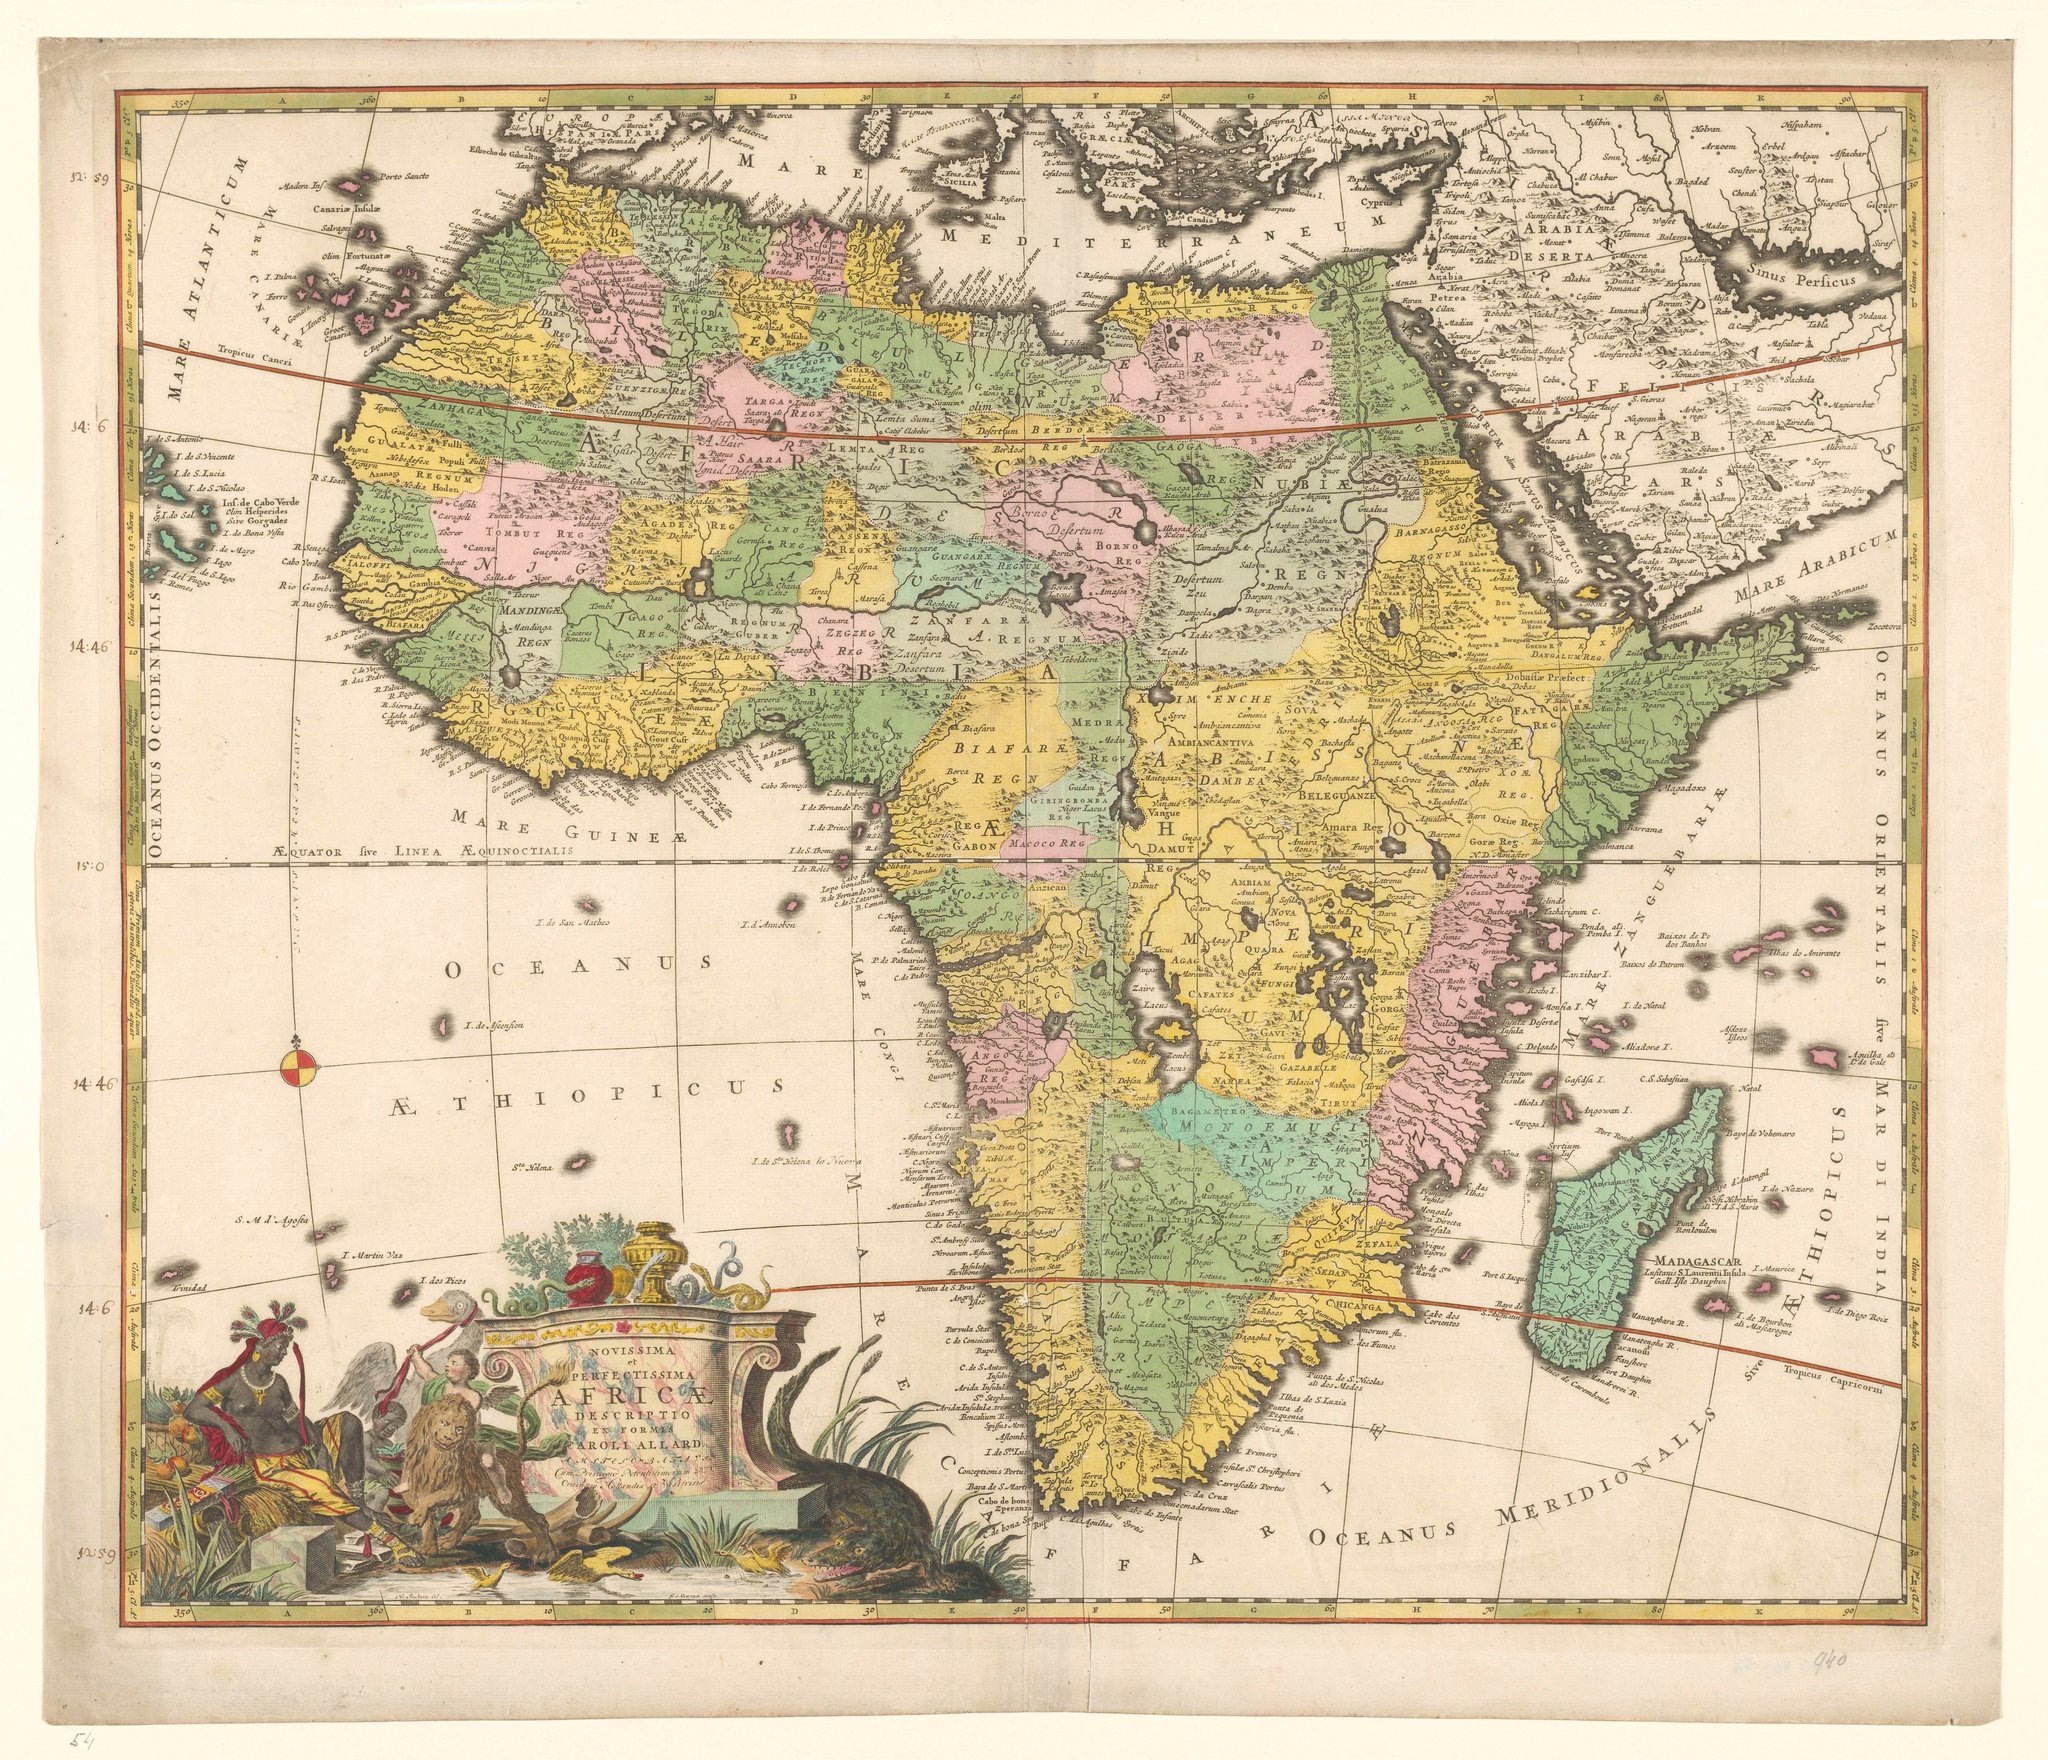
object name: map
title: Novissima et perfectissima Africae descriptio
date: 1690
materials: ink, paper, watercolor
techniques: engraving, etching, hand coloring, pen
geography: amsterdam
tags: maps of separate countries or regions, africa represented allegorically; 'africa' (ripa), africans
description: Kaart van Afrika, rood omrand, gebieden gekleurd. Kompasroos linksonder de cartouche met titel en allegorische figuren, de vrouwelijke personificatie van Afrika en Afrikaanse dieren en vegetatie. Links naast de kaart in handschrift de parallellen extra genummerd.